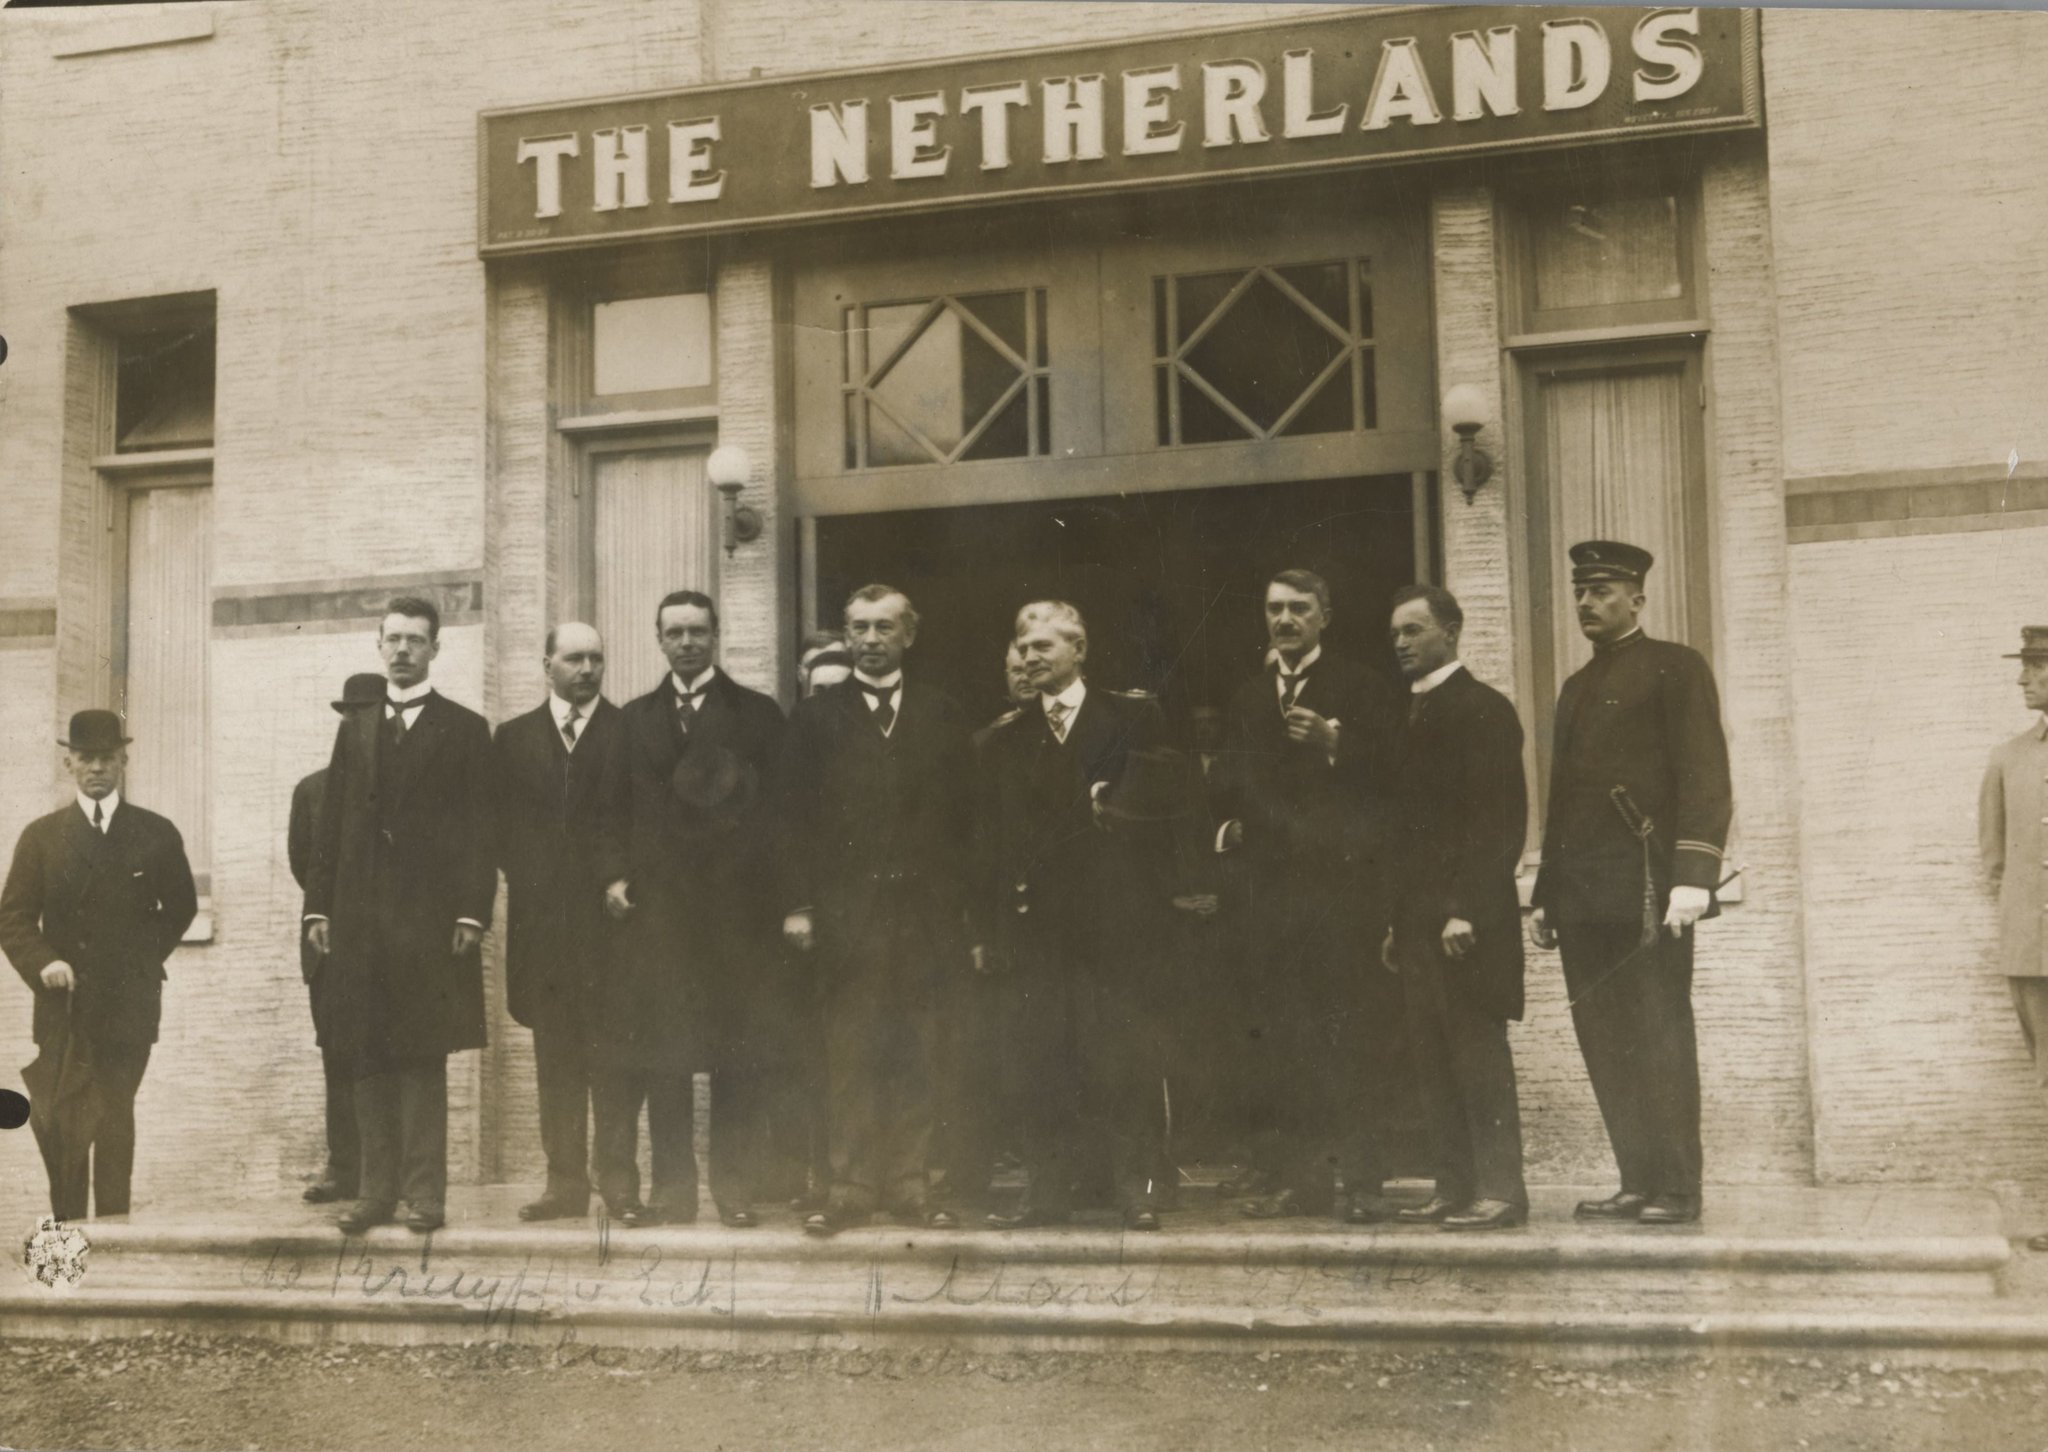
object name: photograph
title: Witsen met groep voor het Nederlands Paviljoen (San Francisco)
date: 1860-1915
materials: paper, photographic support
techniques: gelatin silver print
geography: san francisco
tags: draughtsman, willem witsen